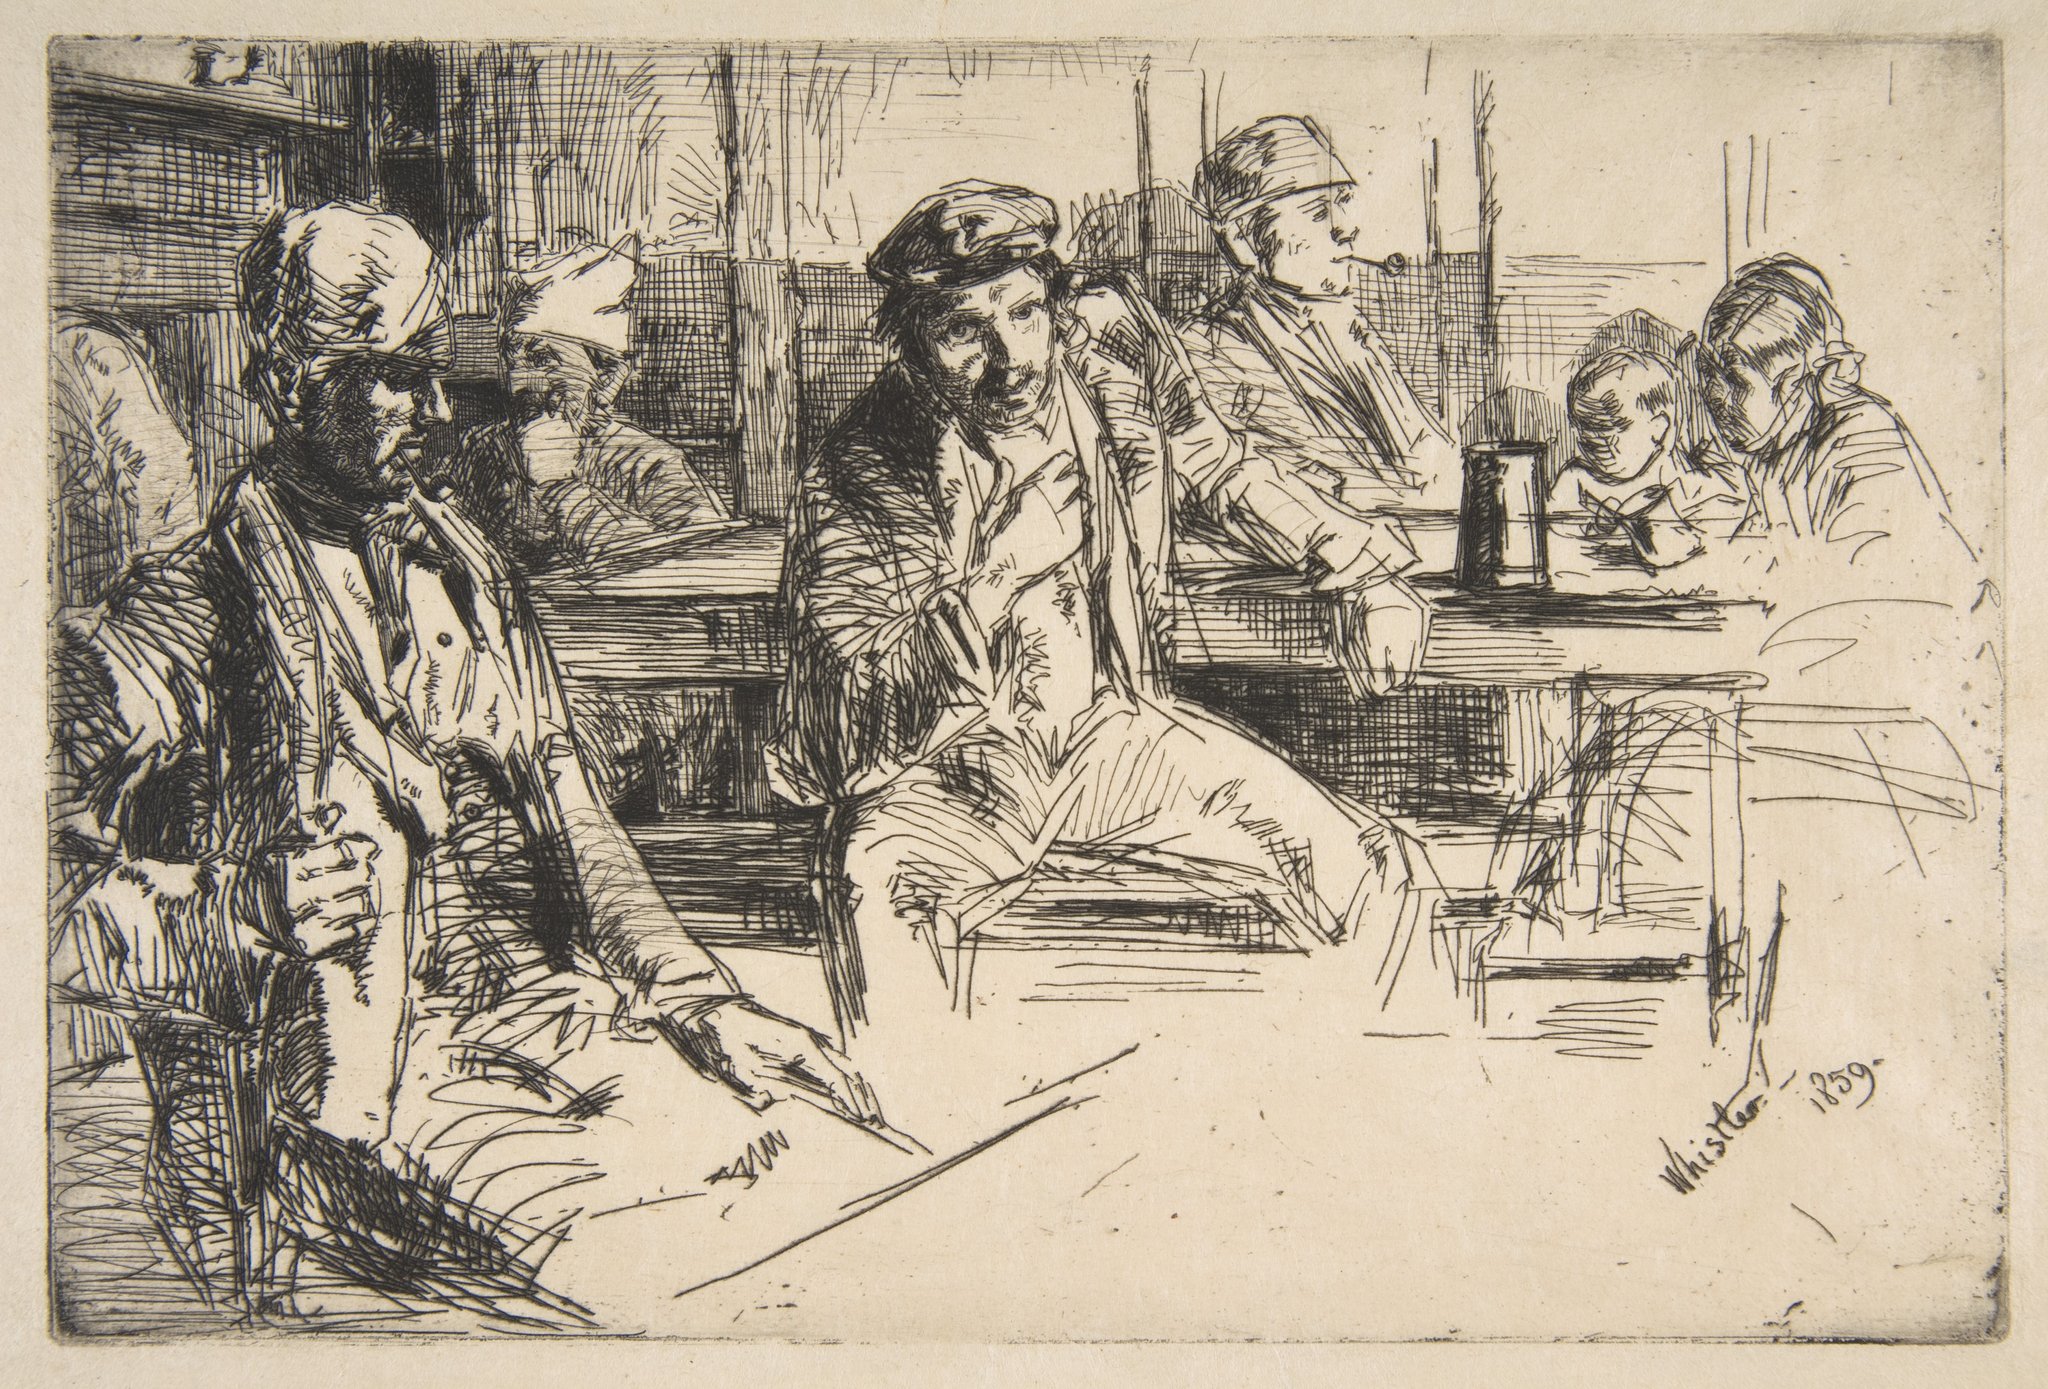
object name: print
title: Longshore Men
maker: james mcneill whistler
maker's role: artist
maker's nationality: american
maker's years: 1834-1903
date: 1859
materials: ink, paper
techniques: drypoint, etching, printing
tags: men,women